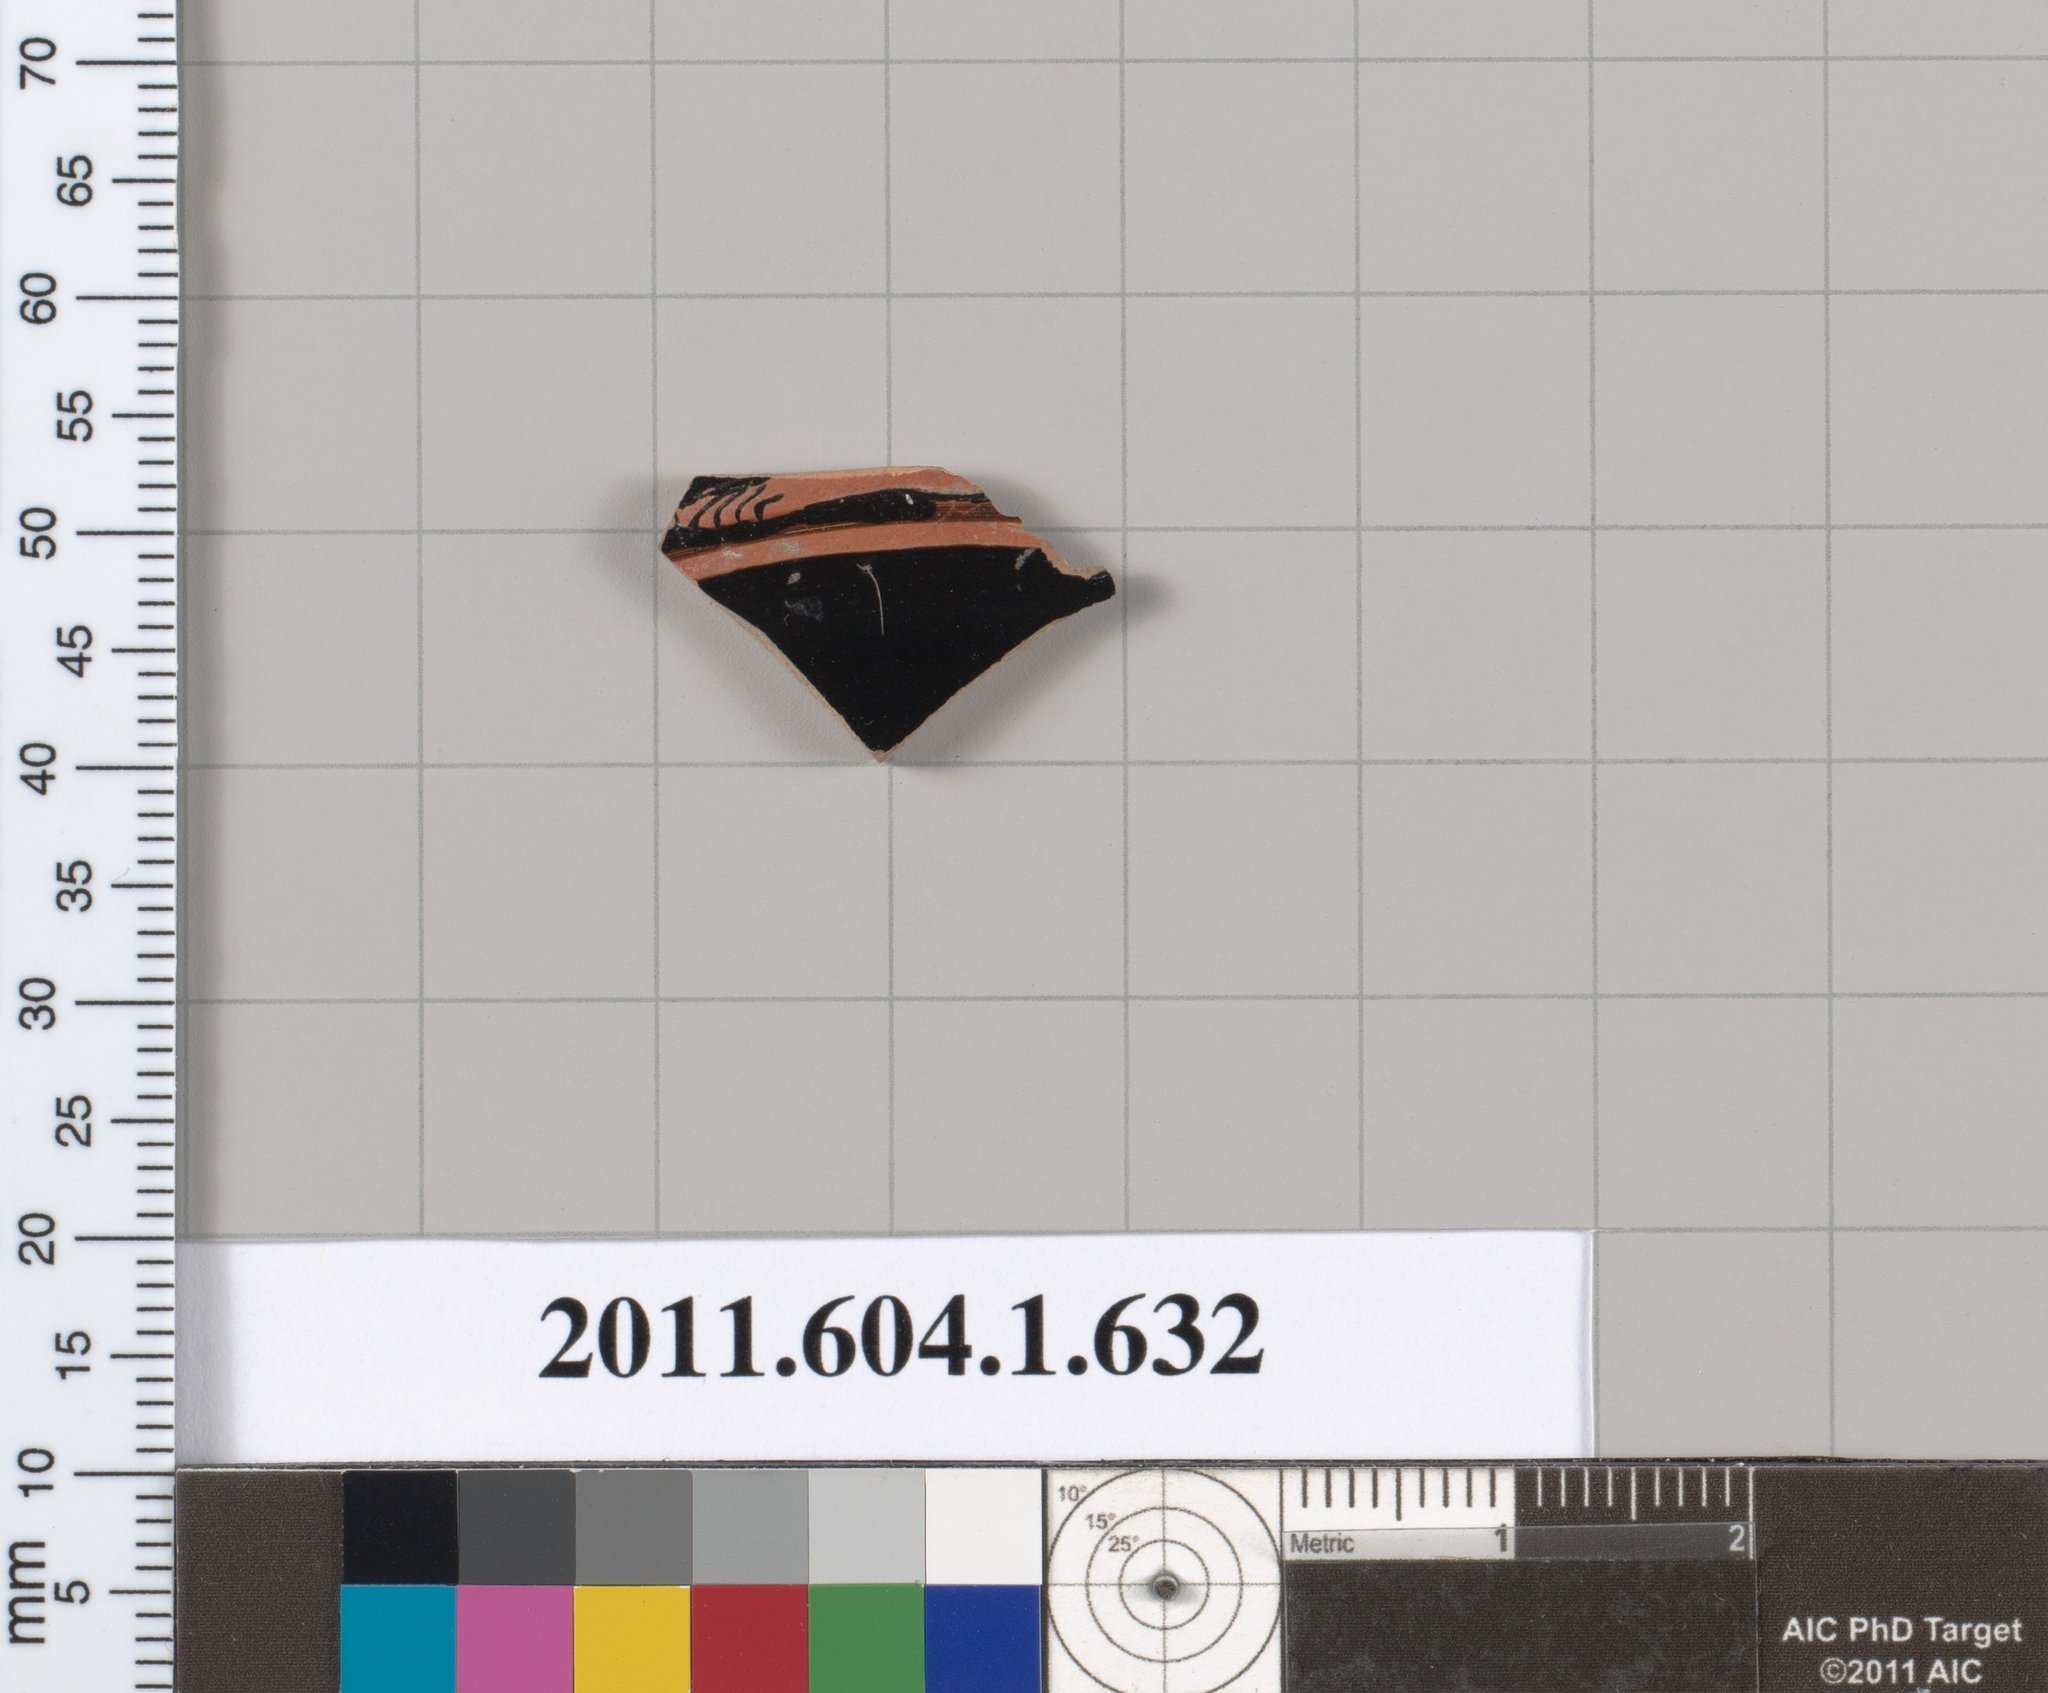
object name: kylix fragment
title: Terracotta fragment of a kylix (drinking cup)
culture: greek, attic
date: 475-451 BCE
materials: terracotta